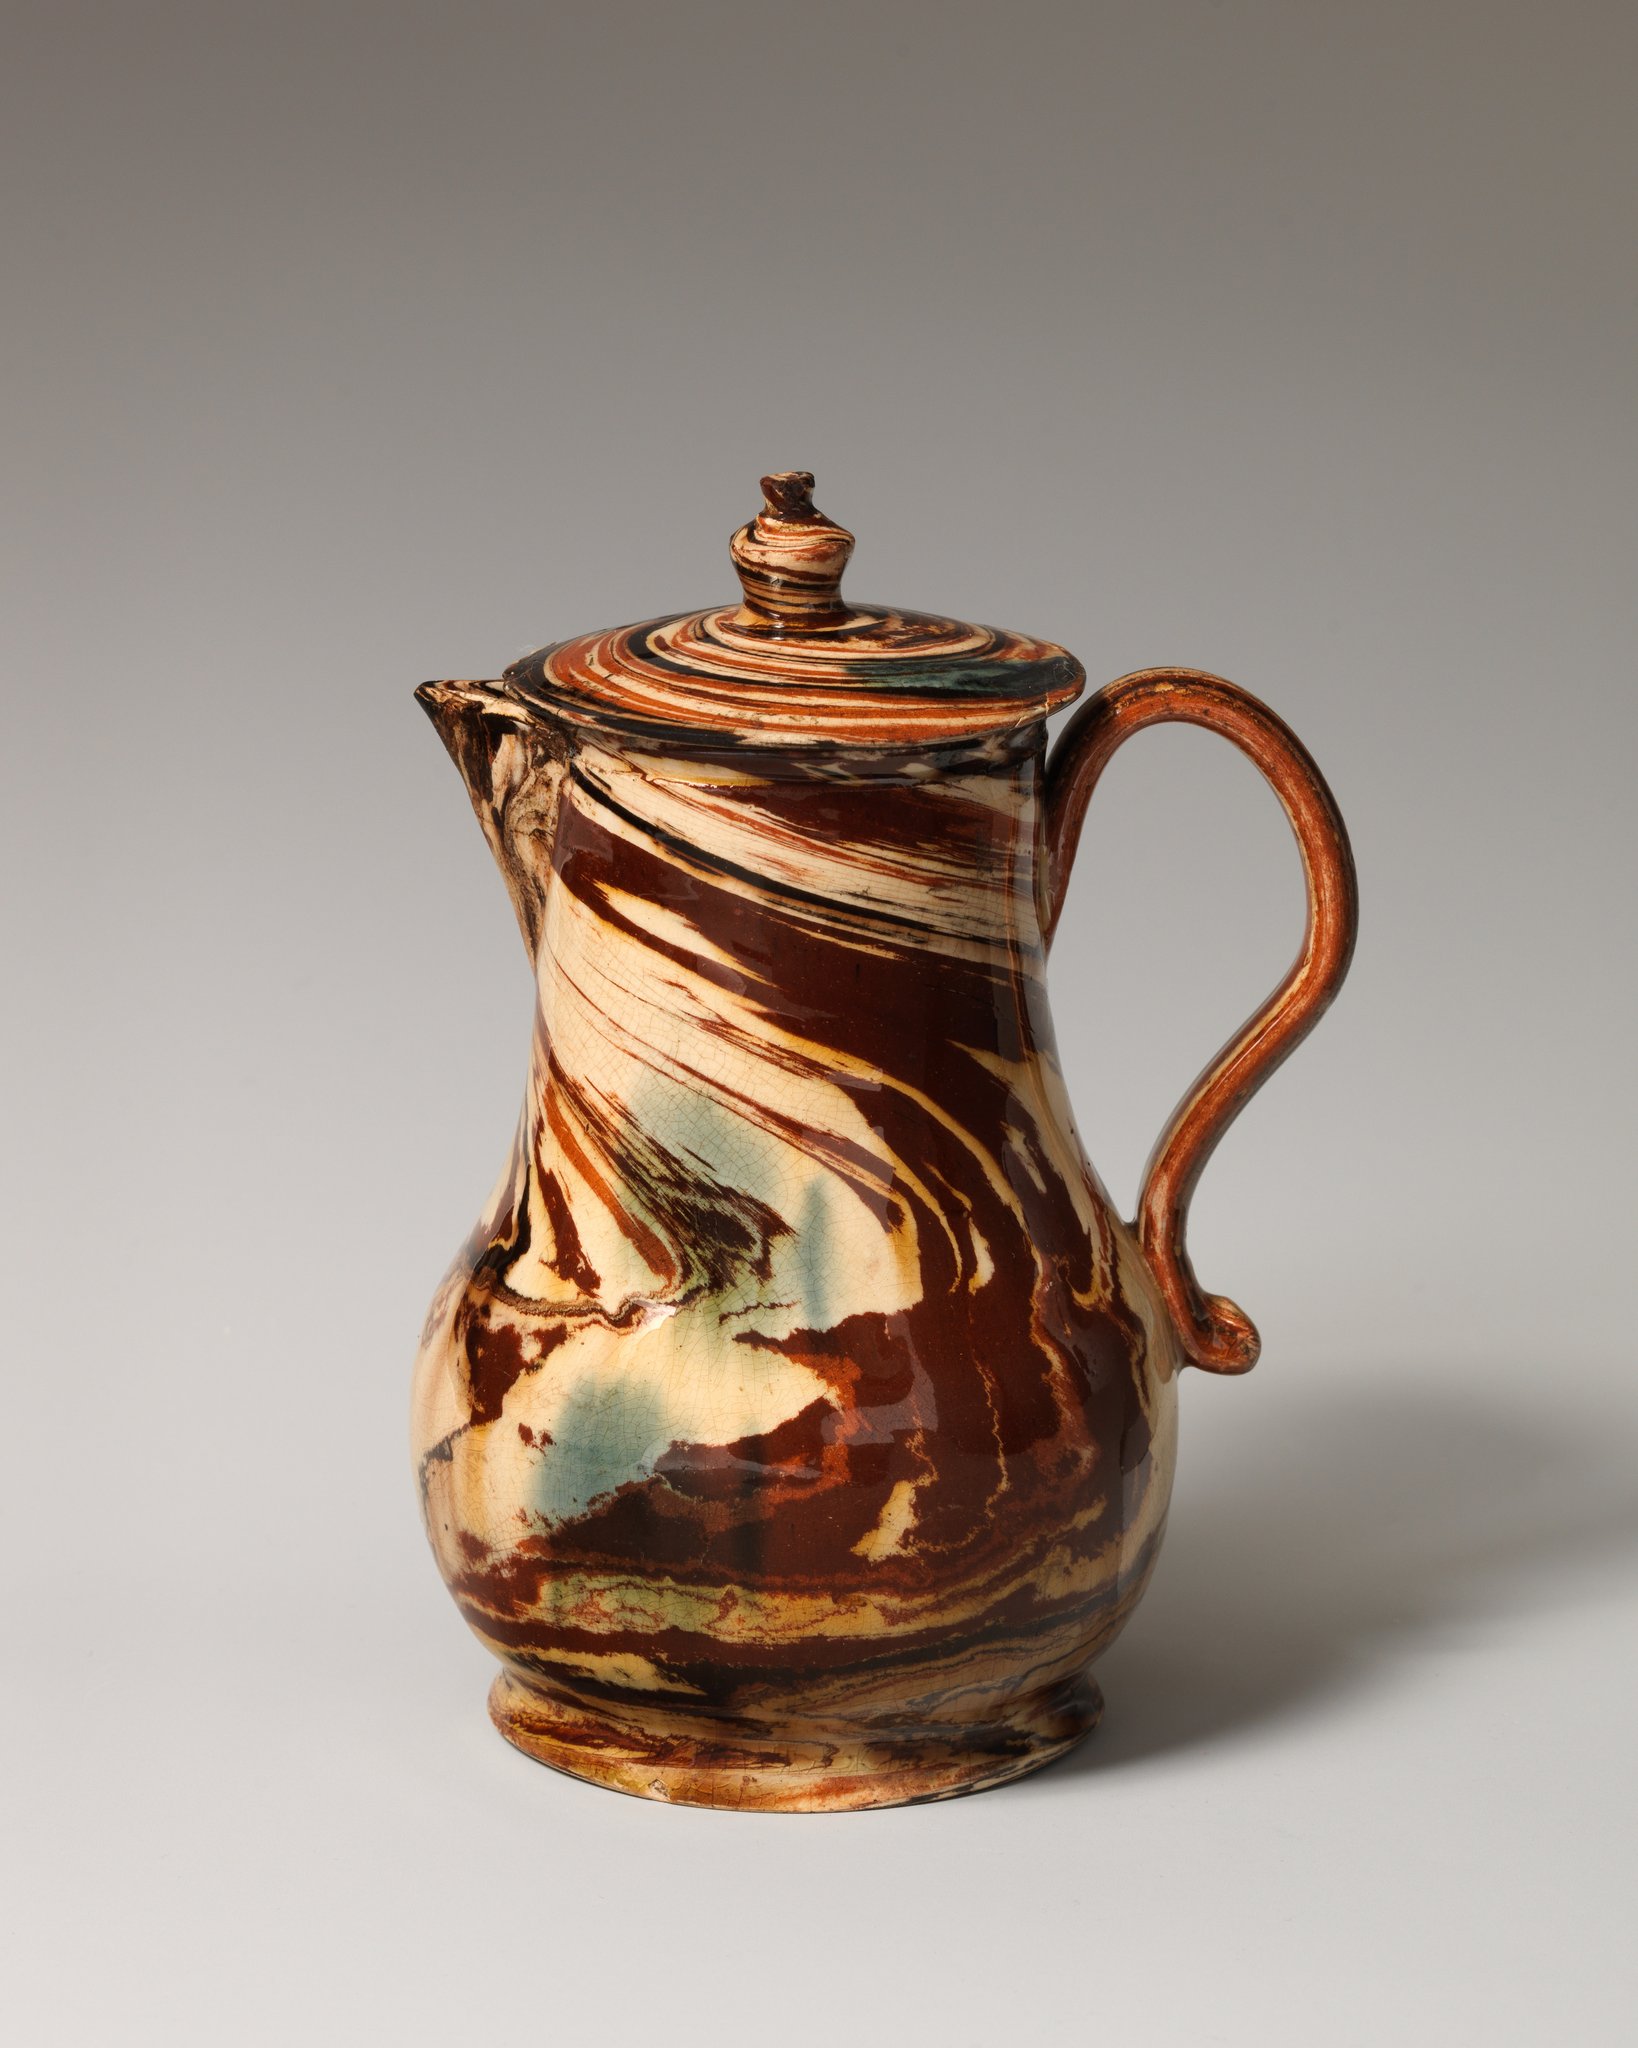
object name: milk pot with cover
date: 1750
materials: earthenware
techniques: glazing